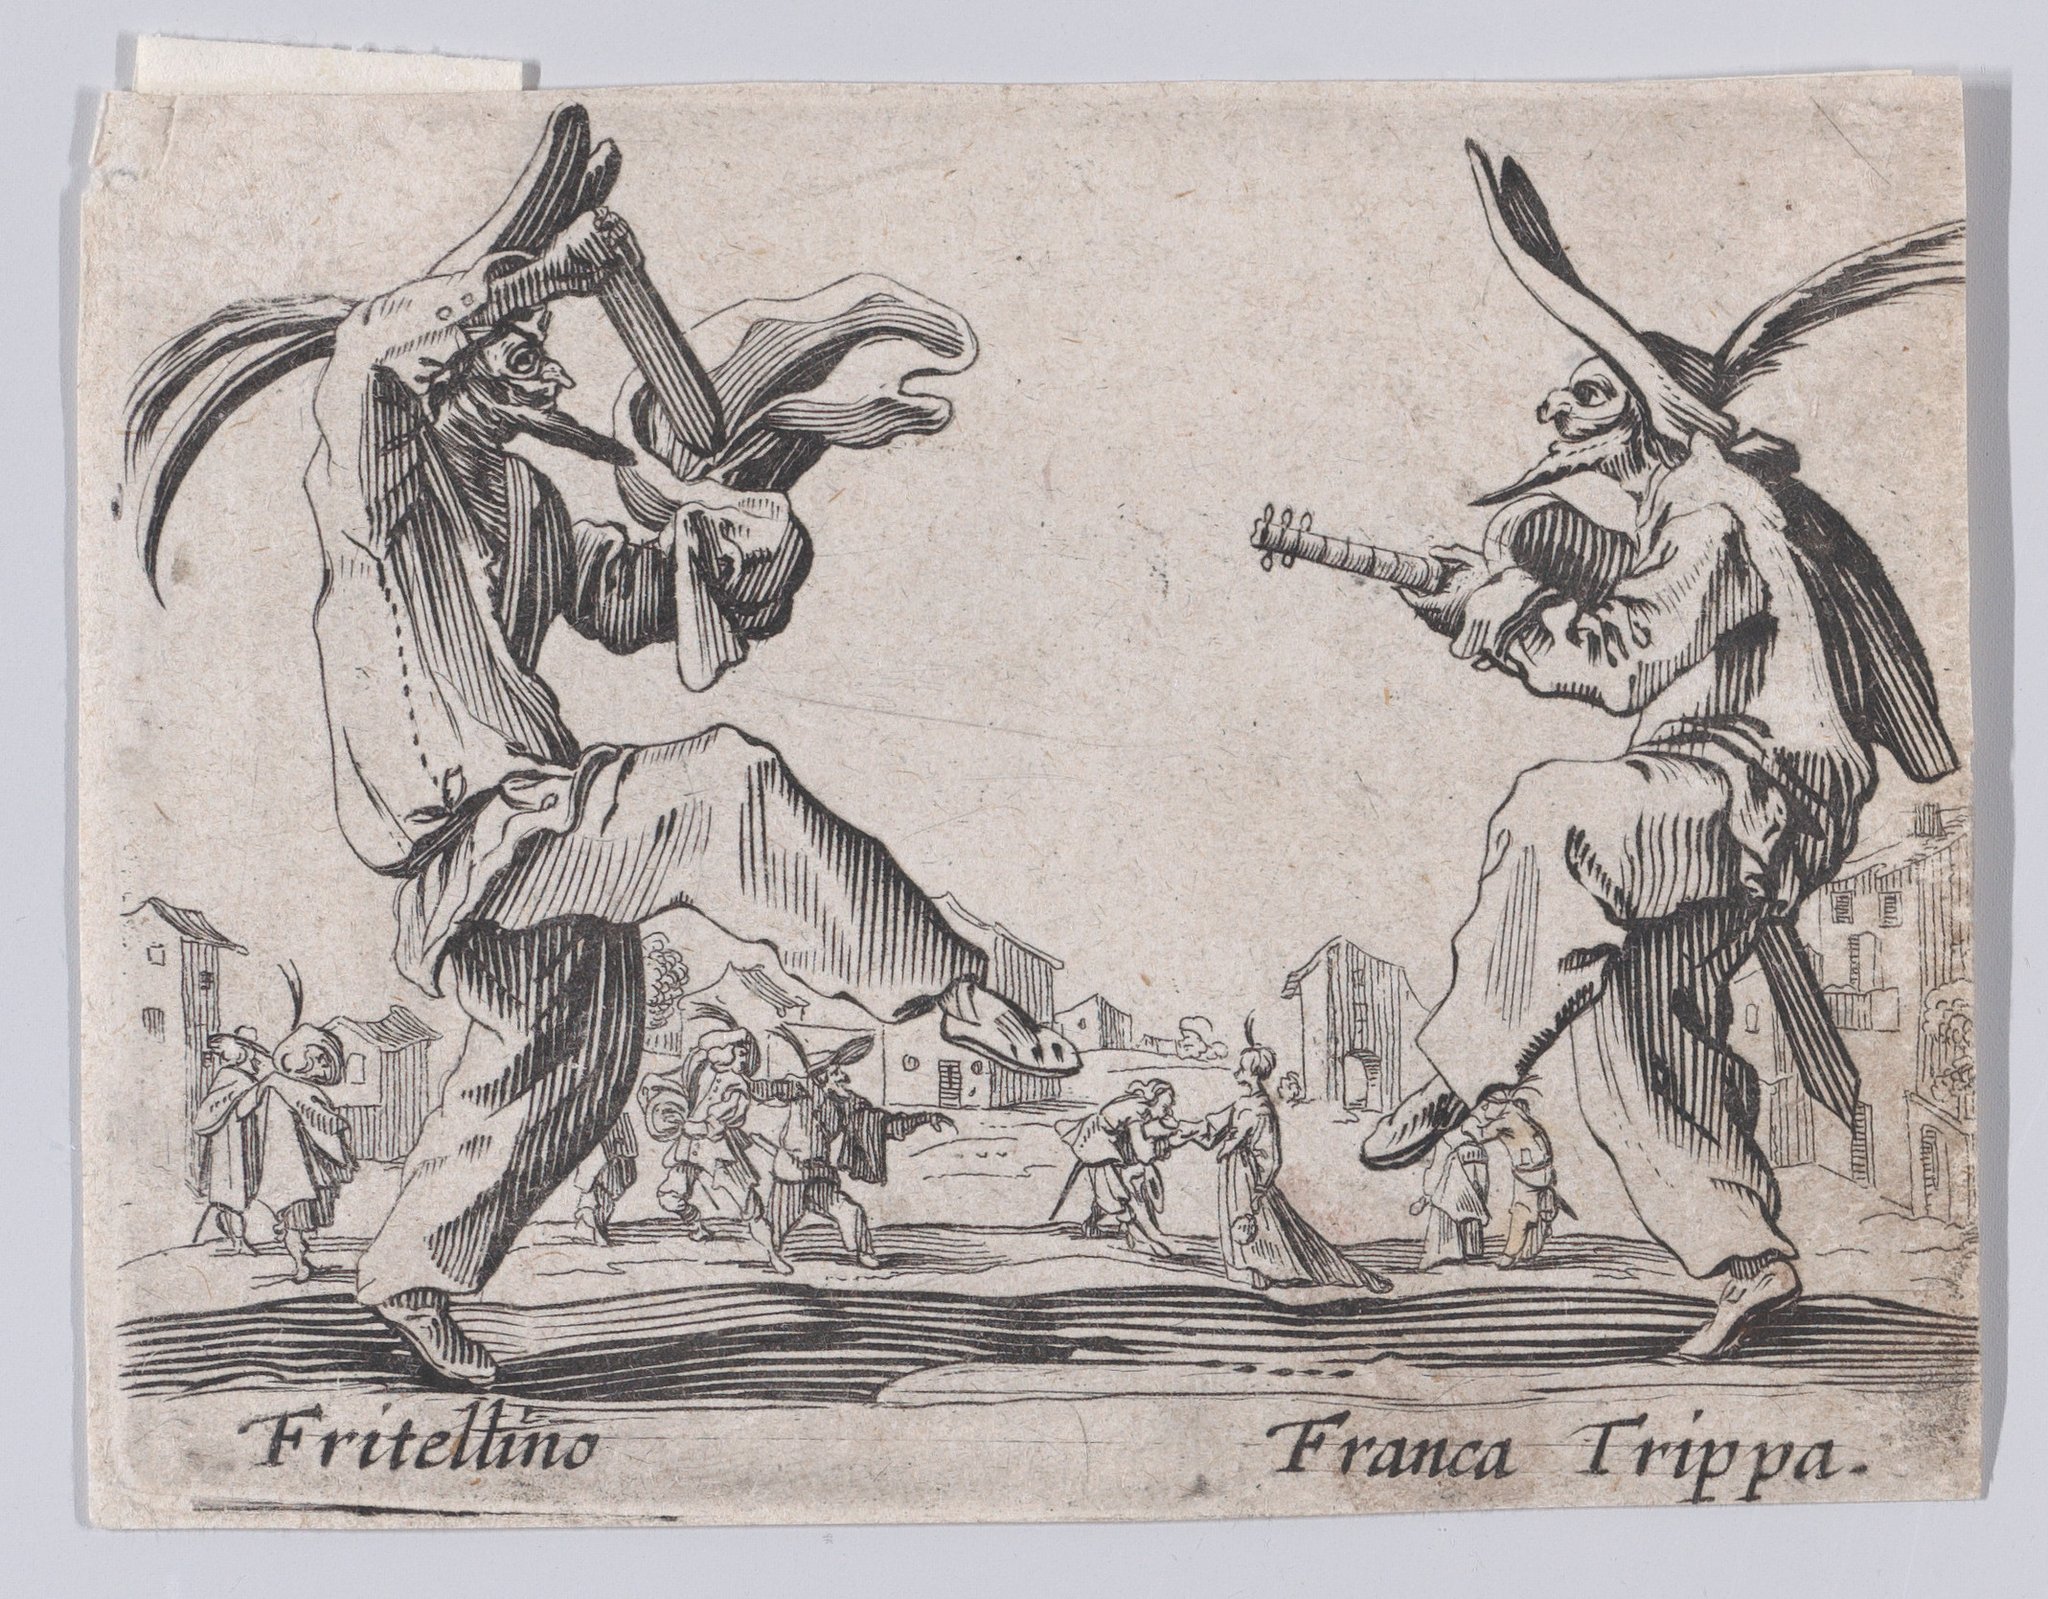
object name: print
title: Copy of Franca Trippa and Fritellino, from "Balli di Sfessania" (Dance of Sfessania)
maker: jacques callot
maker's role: artist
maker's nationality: french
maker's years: 1592-1635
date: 1622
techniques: etching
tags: men,dancing